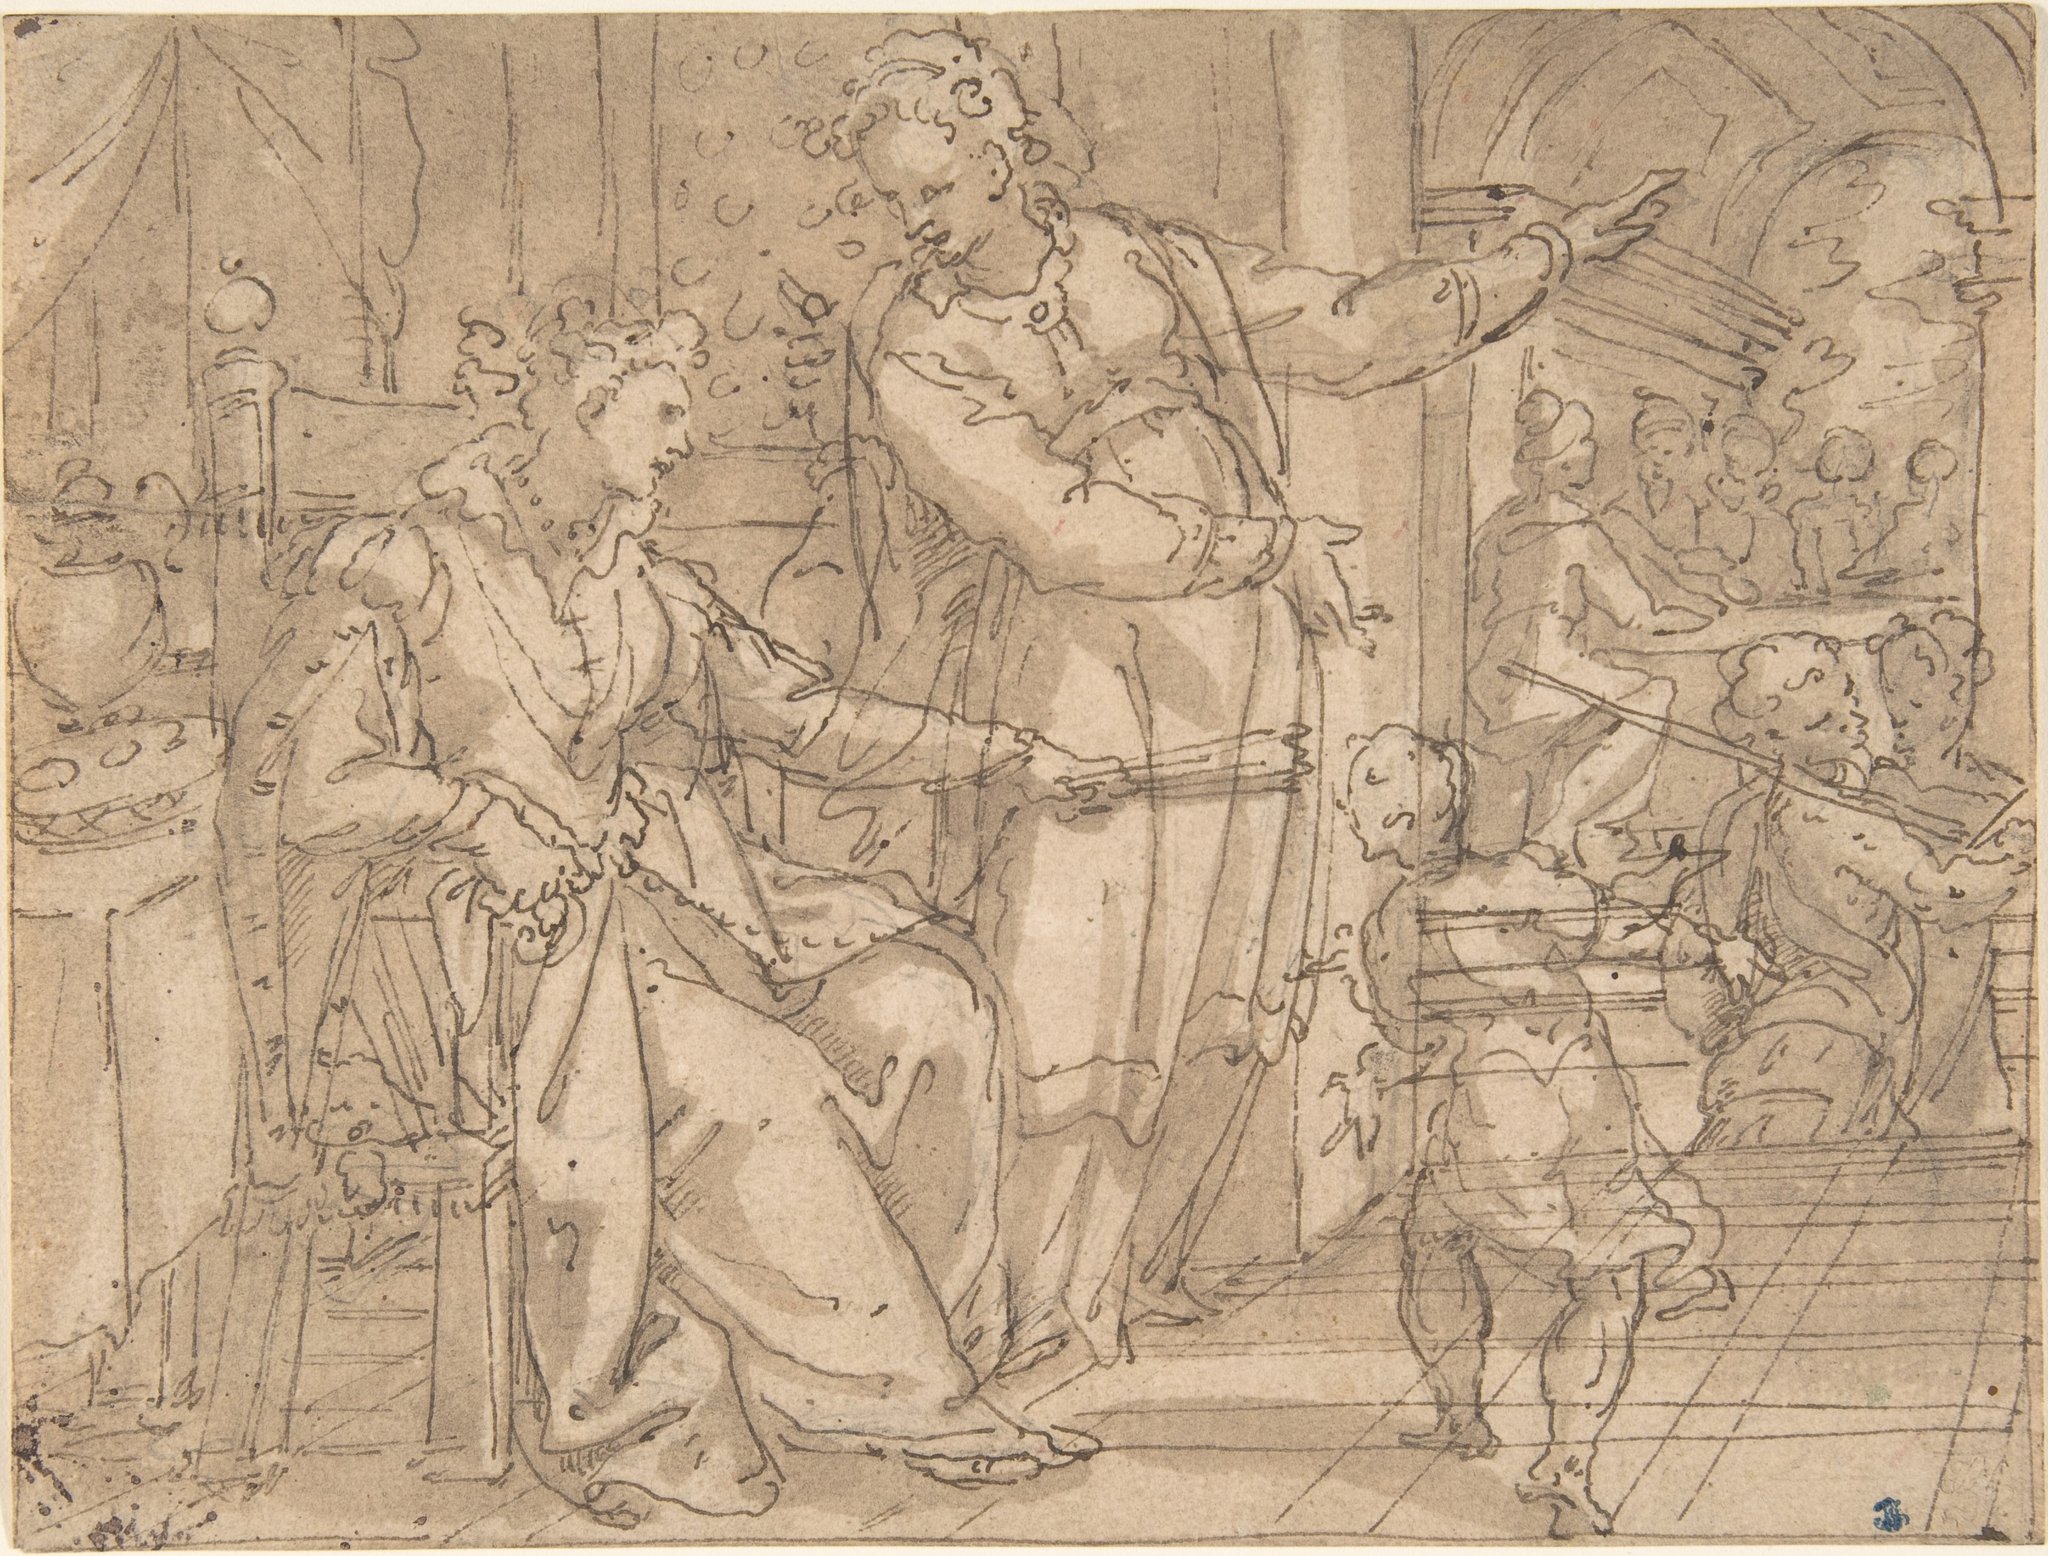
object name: drawing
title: Two Women Talking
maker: hans weiner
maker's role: artist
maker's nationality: german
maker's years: 1575-1619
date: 1567-1633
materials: ink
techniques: pen, wash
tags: women